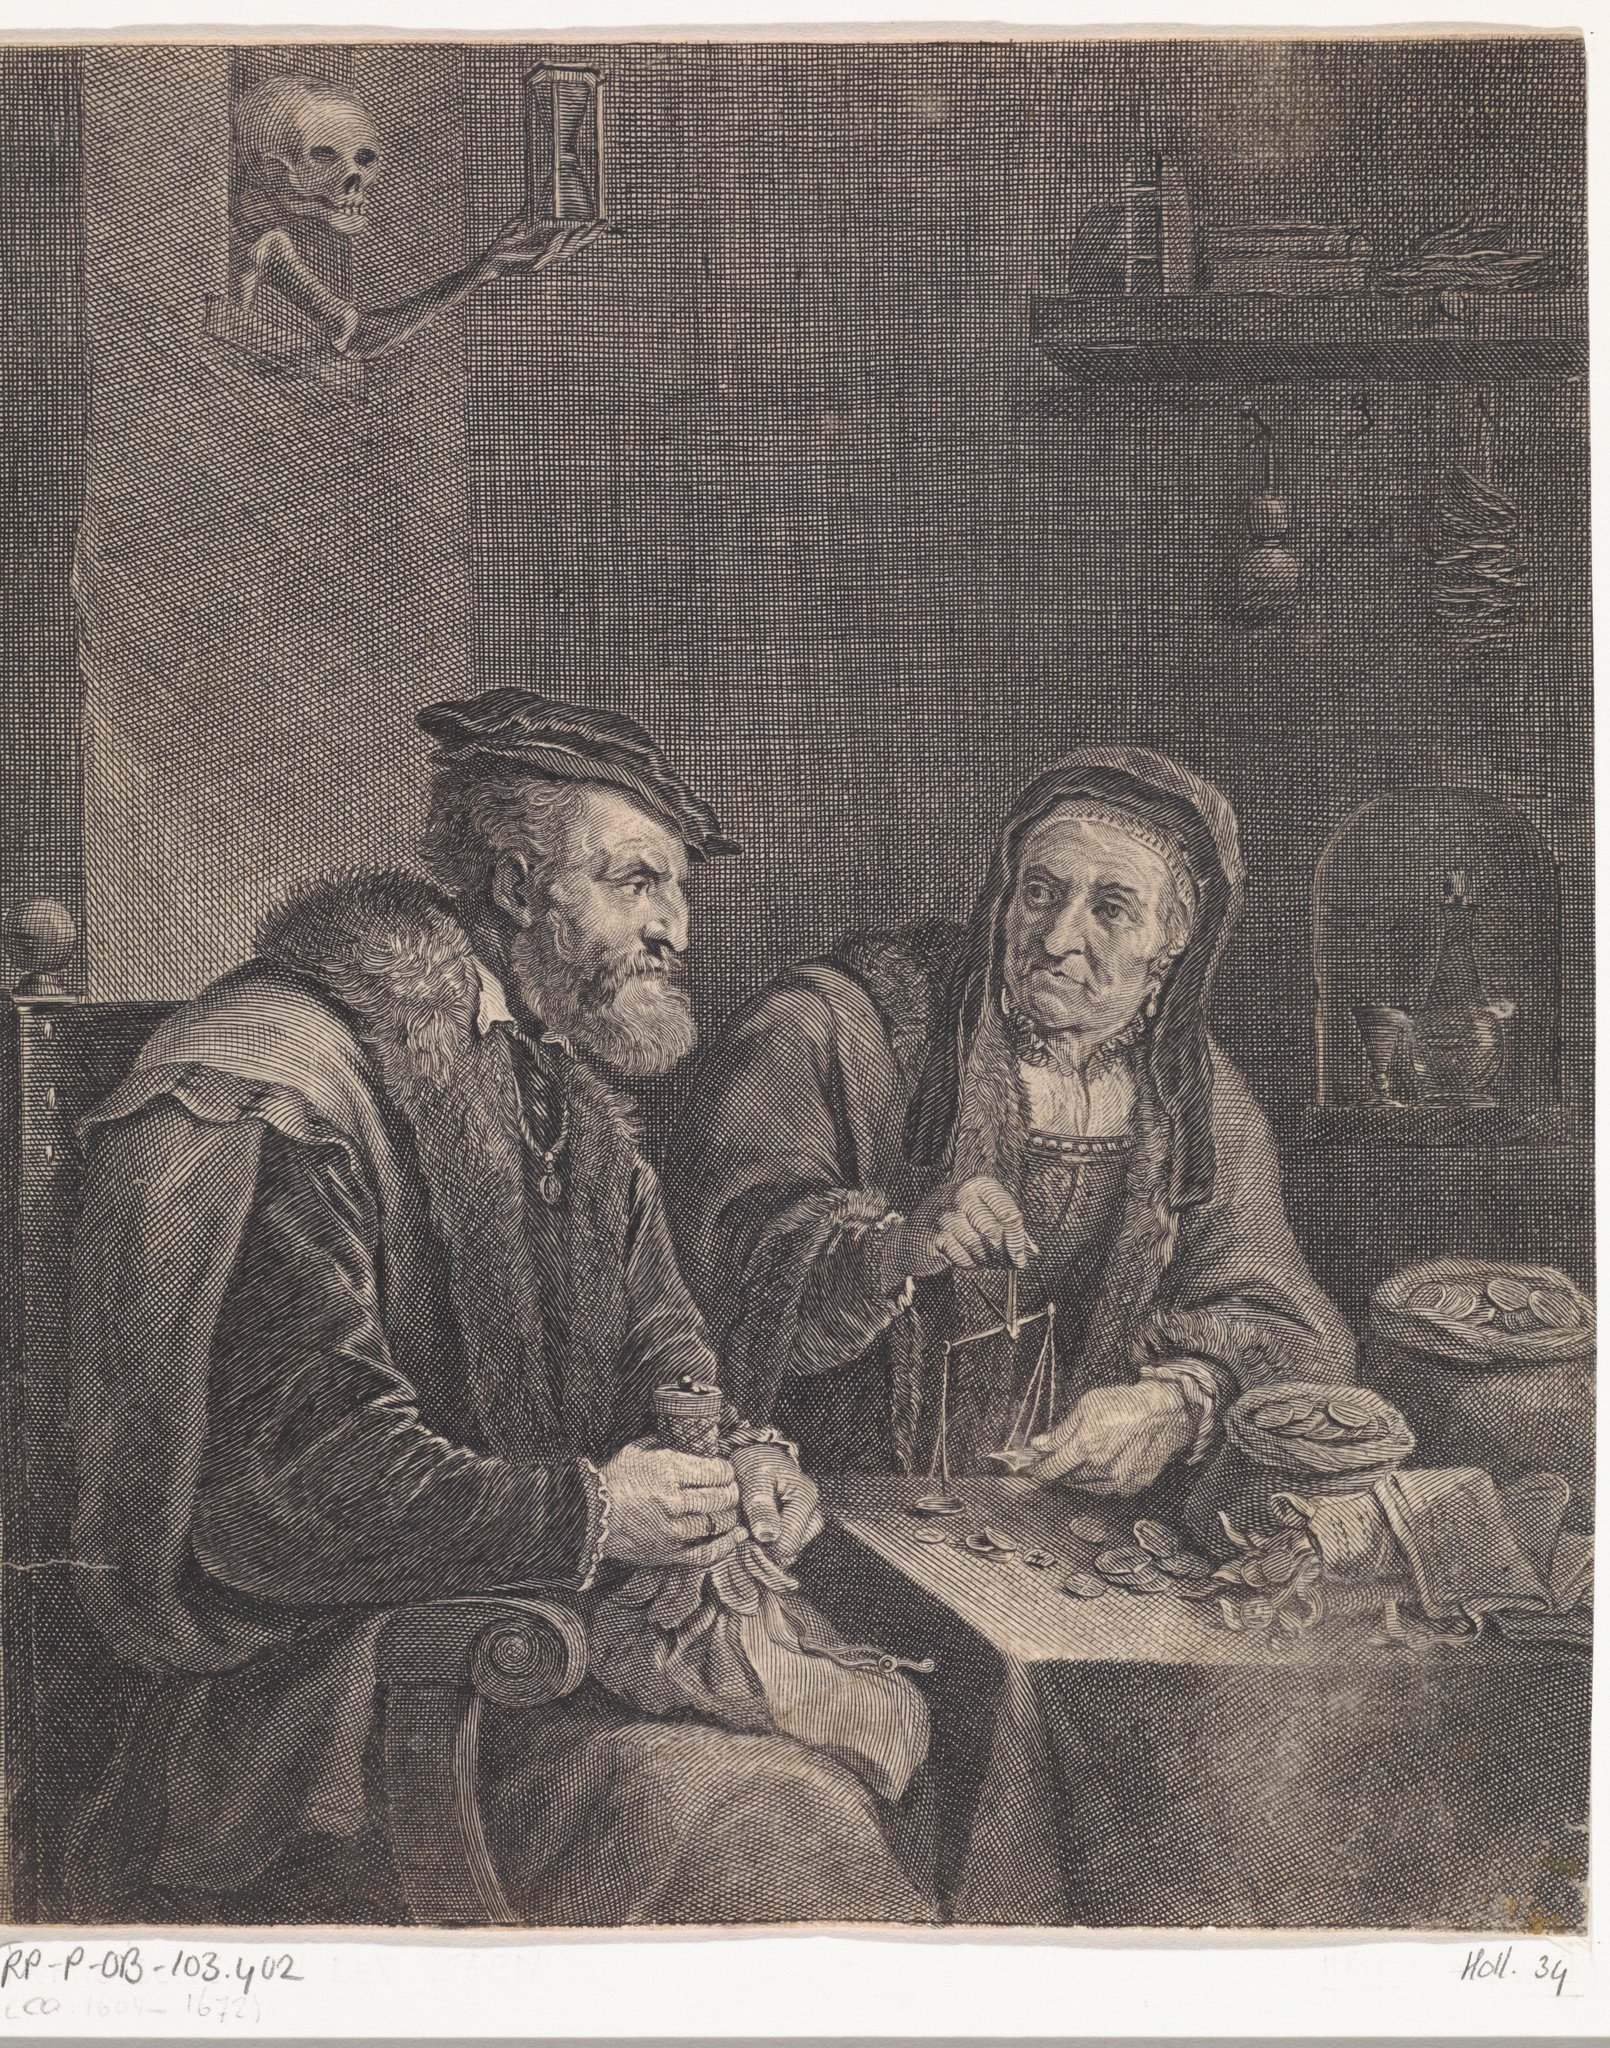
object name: print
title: Paar weegt geld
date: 1643-1672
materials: paper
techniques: engraving, etching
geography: antwerp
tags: death as skeleton, hourglass, weighing gold or money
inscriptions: collector's mark: Lugt 2228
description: In een vertrek weegt een vrouw geld, terwijl haar man naast haar zit met een stokbeurs op schoot. Vanuit een venster slaat de Dood, met in de hand een zandloper, het tafereel gade.